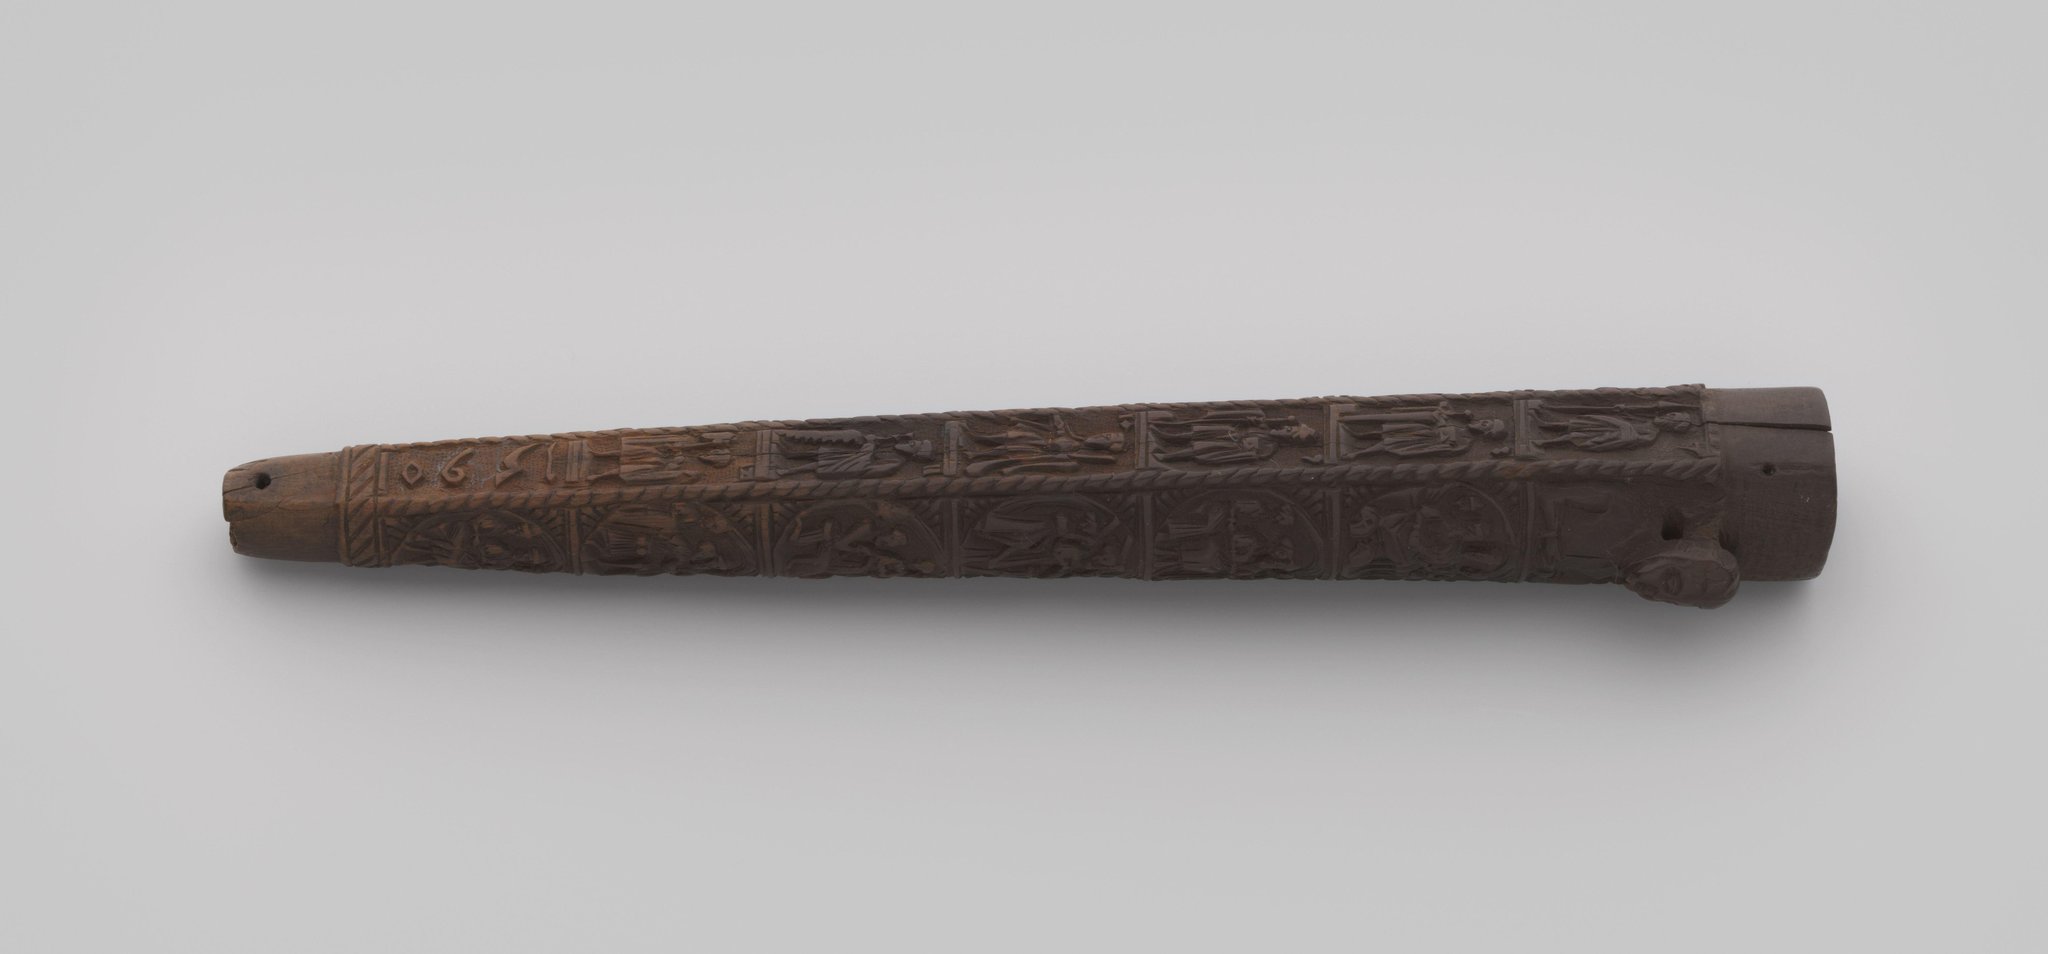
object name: knife with sheath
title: Messchede van hout met afbeeldingen van de verloren zoon en van de geschiedenis van Job en de twaalf apostelen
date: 1590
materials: wood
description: Houten messchede met afbeeldingen van de verloren zoon en de geschiedenis van Job en de 12 apostelen. Gemerkt.